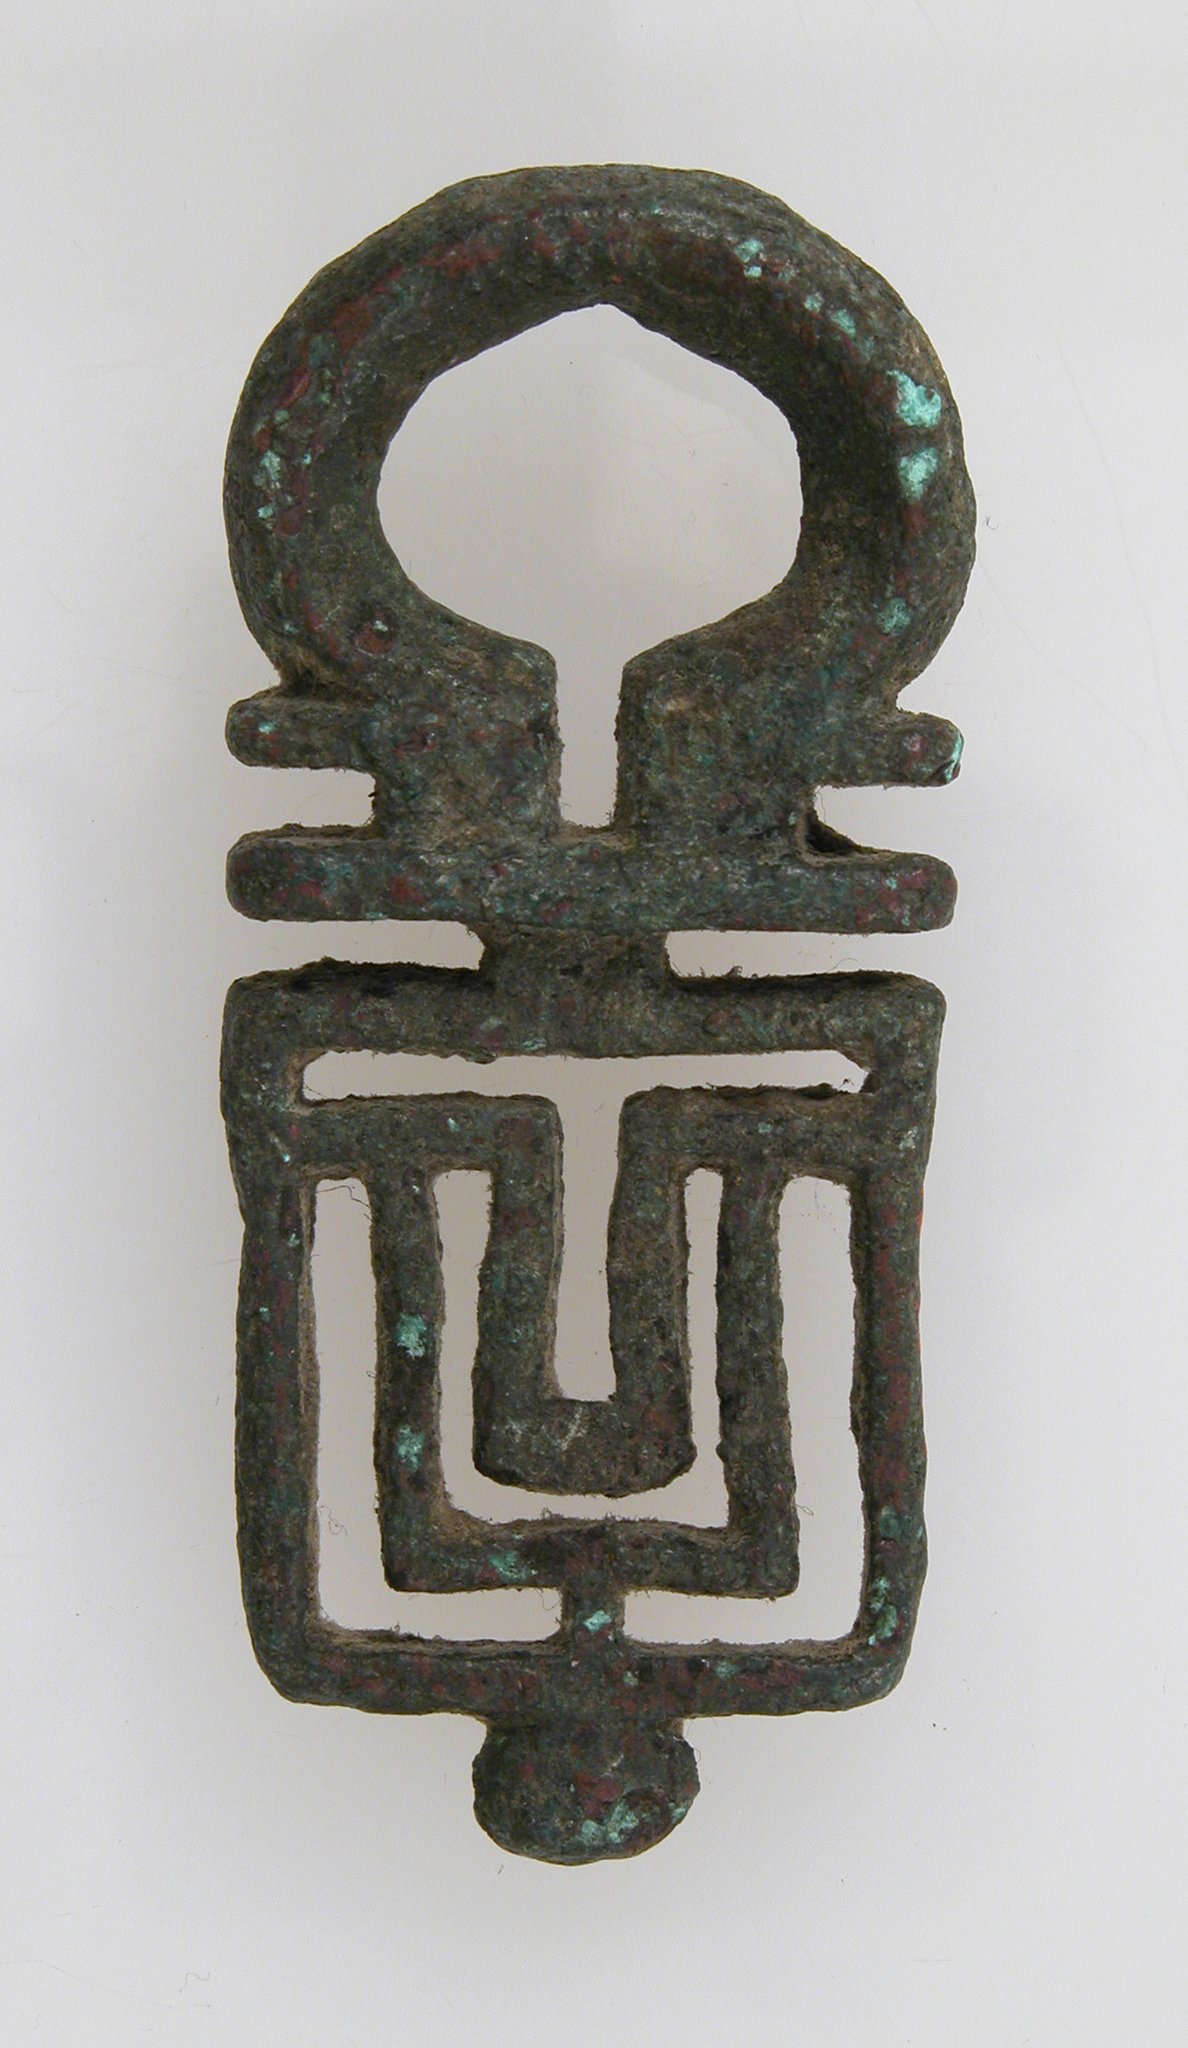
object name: key latch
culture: roman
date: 1-700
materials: copper alloy